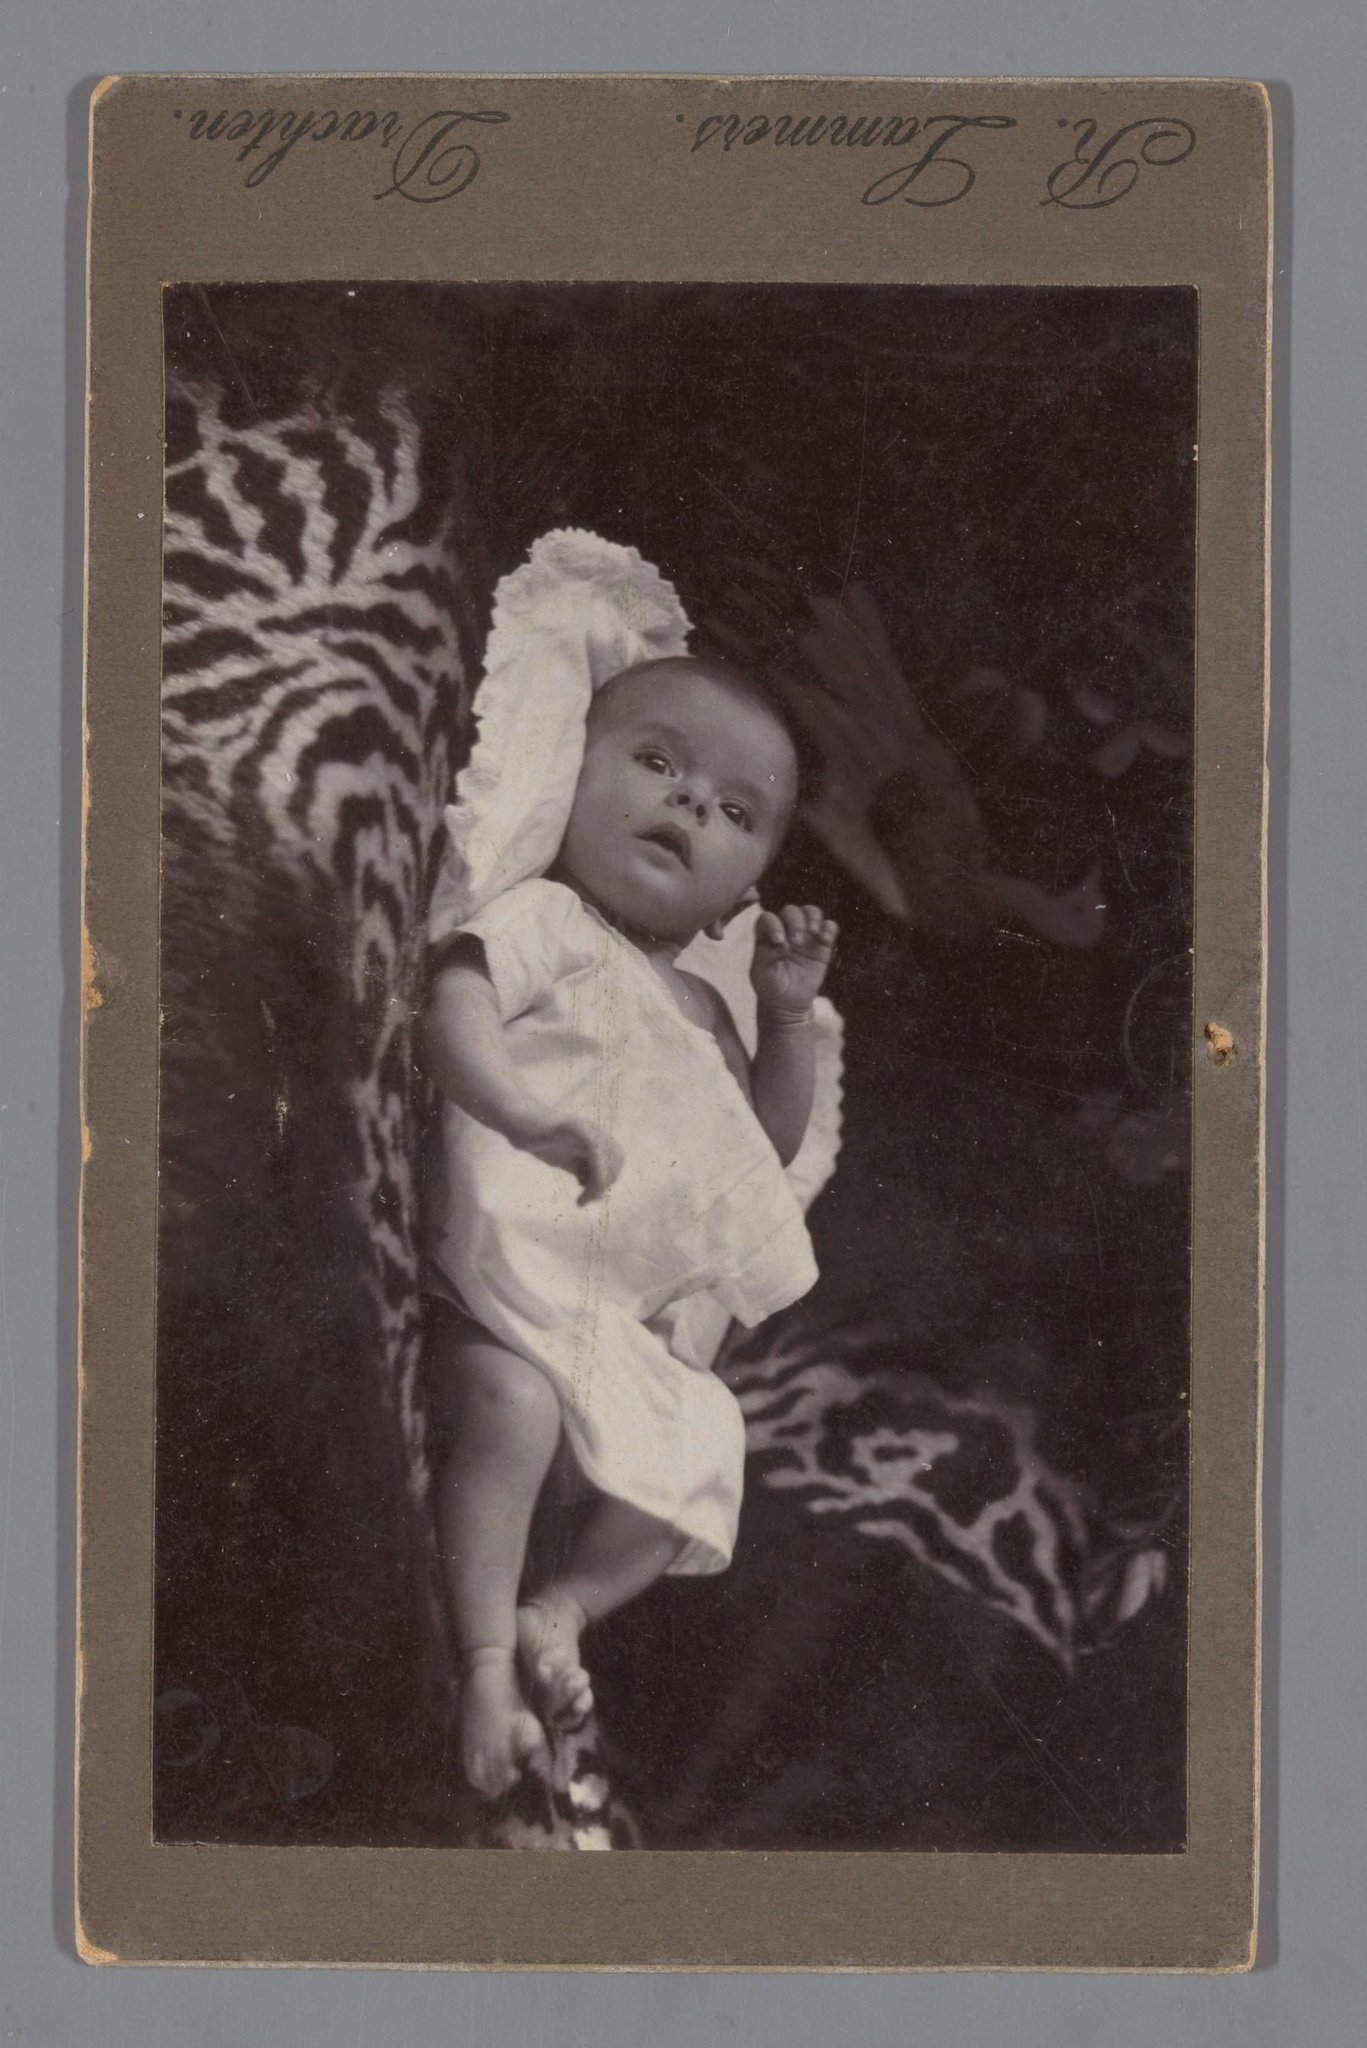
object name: photograph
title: Portret van een baby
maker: roelof pieters lammers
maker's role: fotograaf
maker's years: 1853-1910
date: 1900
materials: cardboard, paper, photographic support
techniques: albumen print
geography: drachten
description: Baby in een wit jurkje, liggend op een kussen op een deken met tijgerachtig motief.